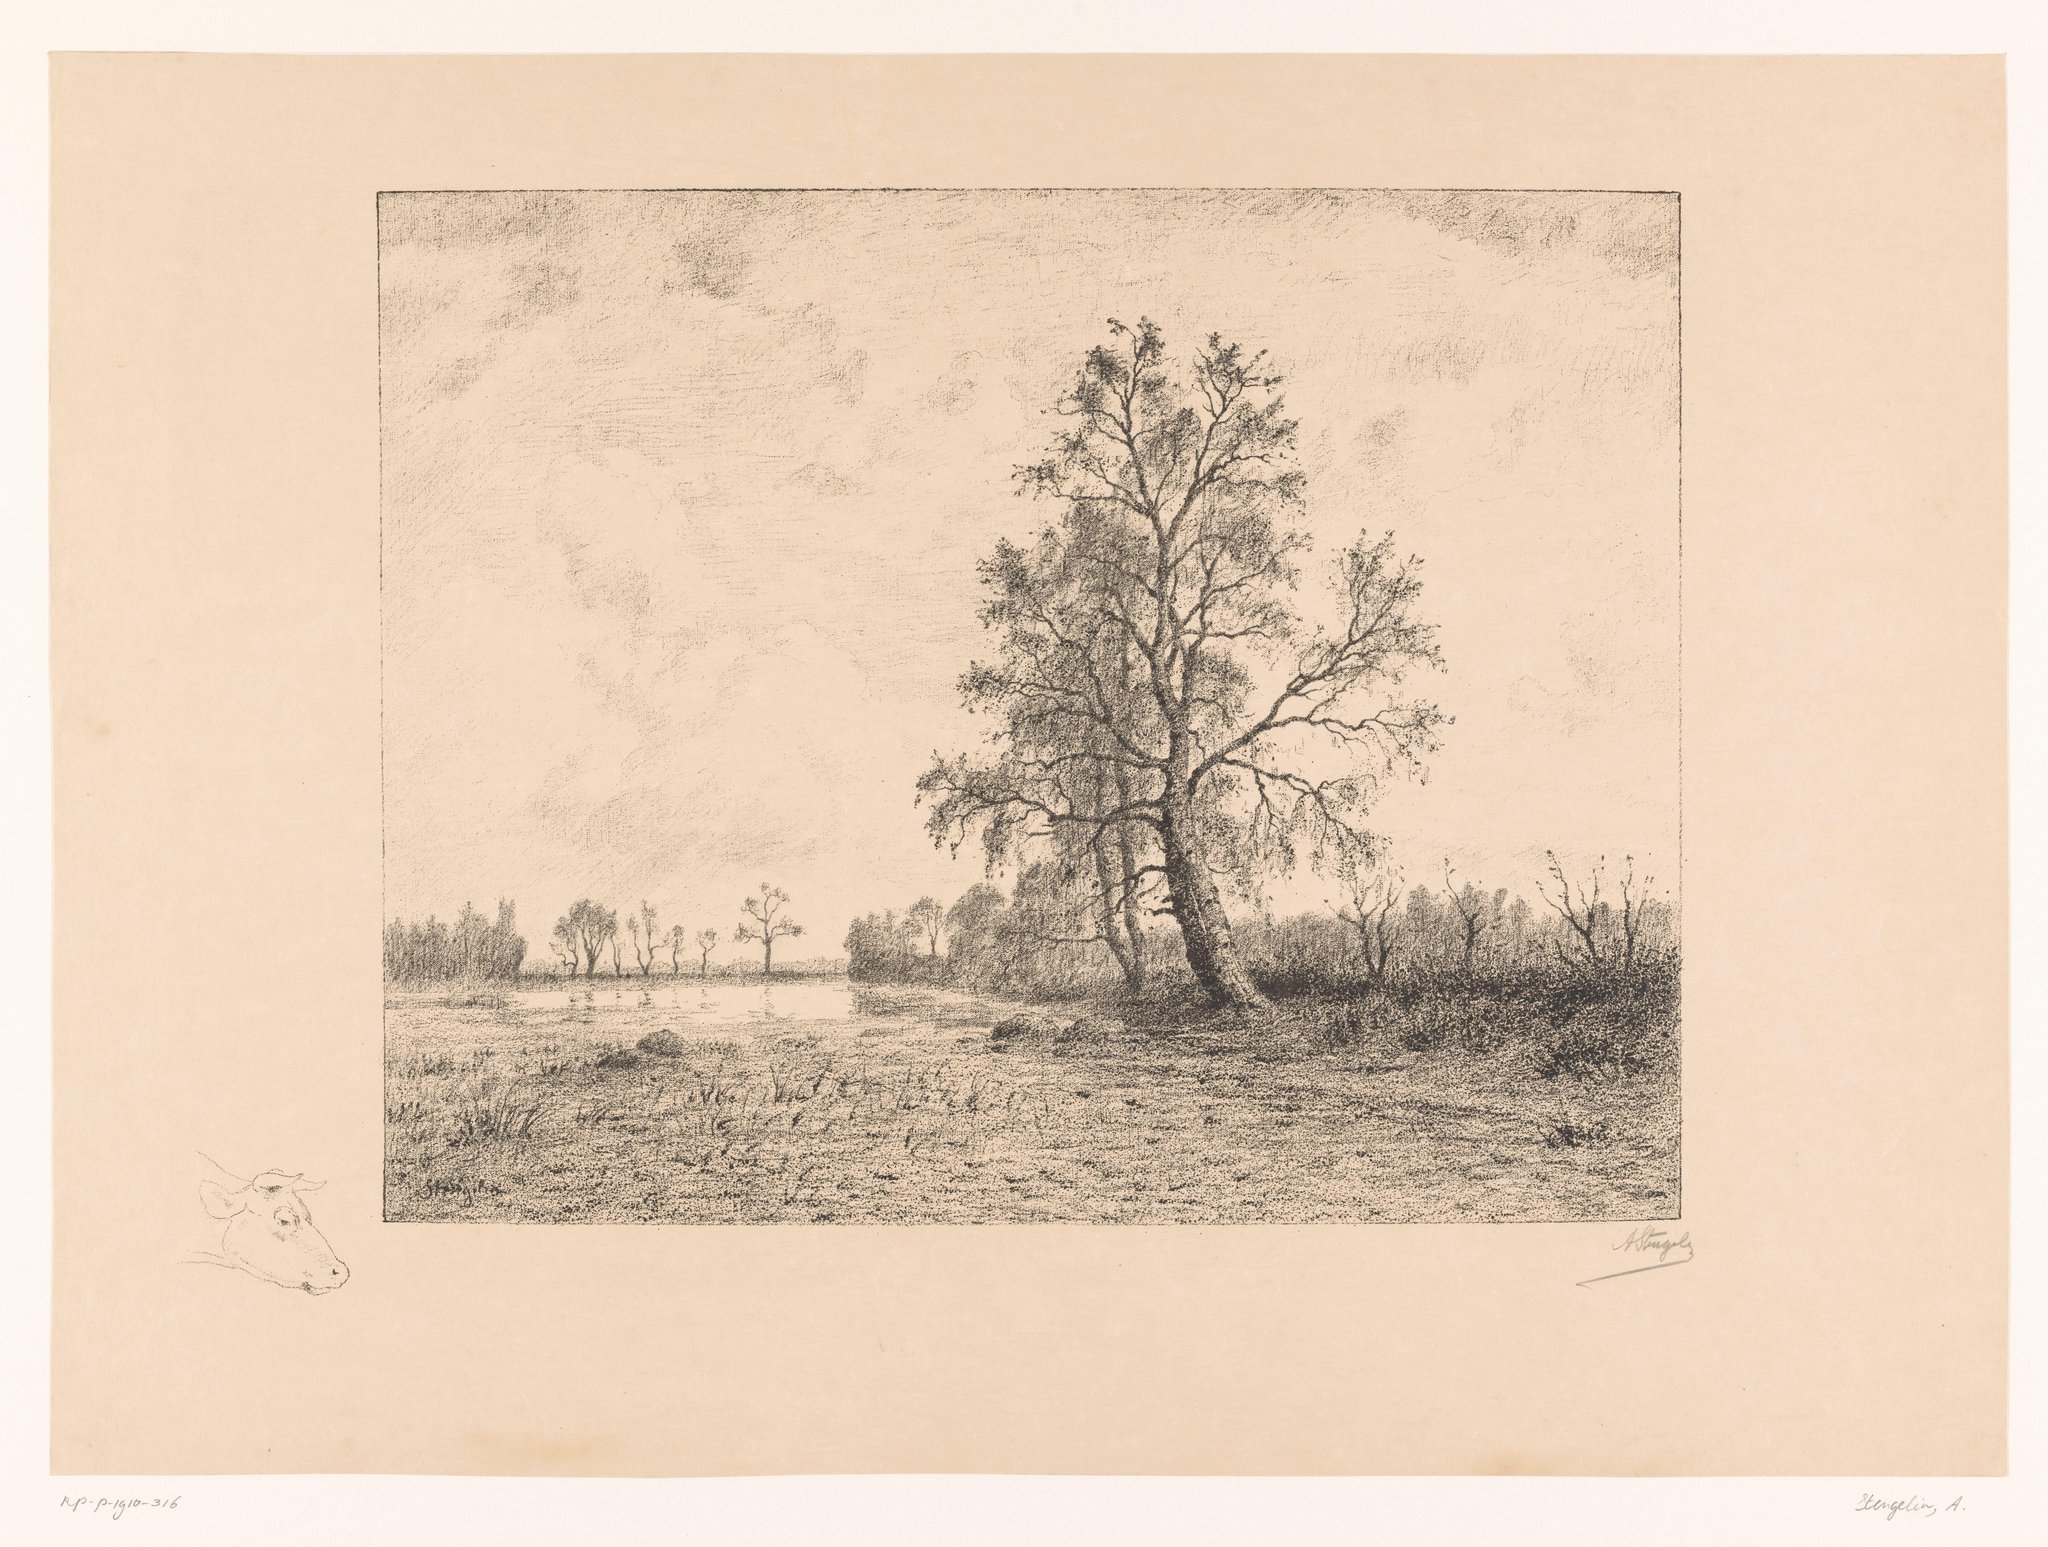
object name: print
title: Gezicht op een plas omringt door bomen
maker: alphonse stengelin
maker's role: painter, print maker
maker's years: 1852-1938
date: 1876-1910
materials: paper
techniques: lithograph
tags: trees, cow, landscapes, lake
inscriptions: collector's mark: Lugt 2228, inscription: ‘15-16’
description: Naast de voorstelling een remarque van kop van een koeienkop.